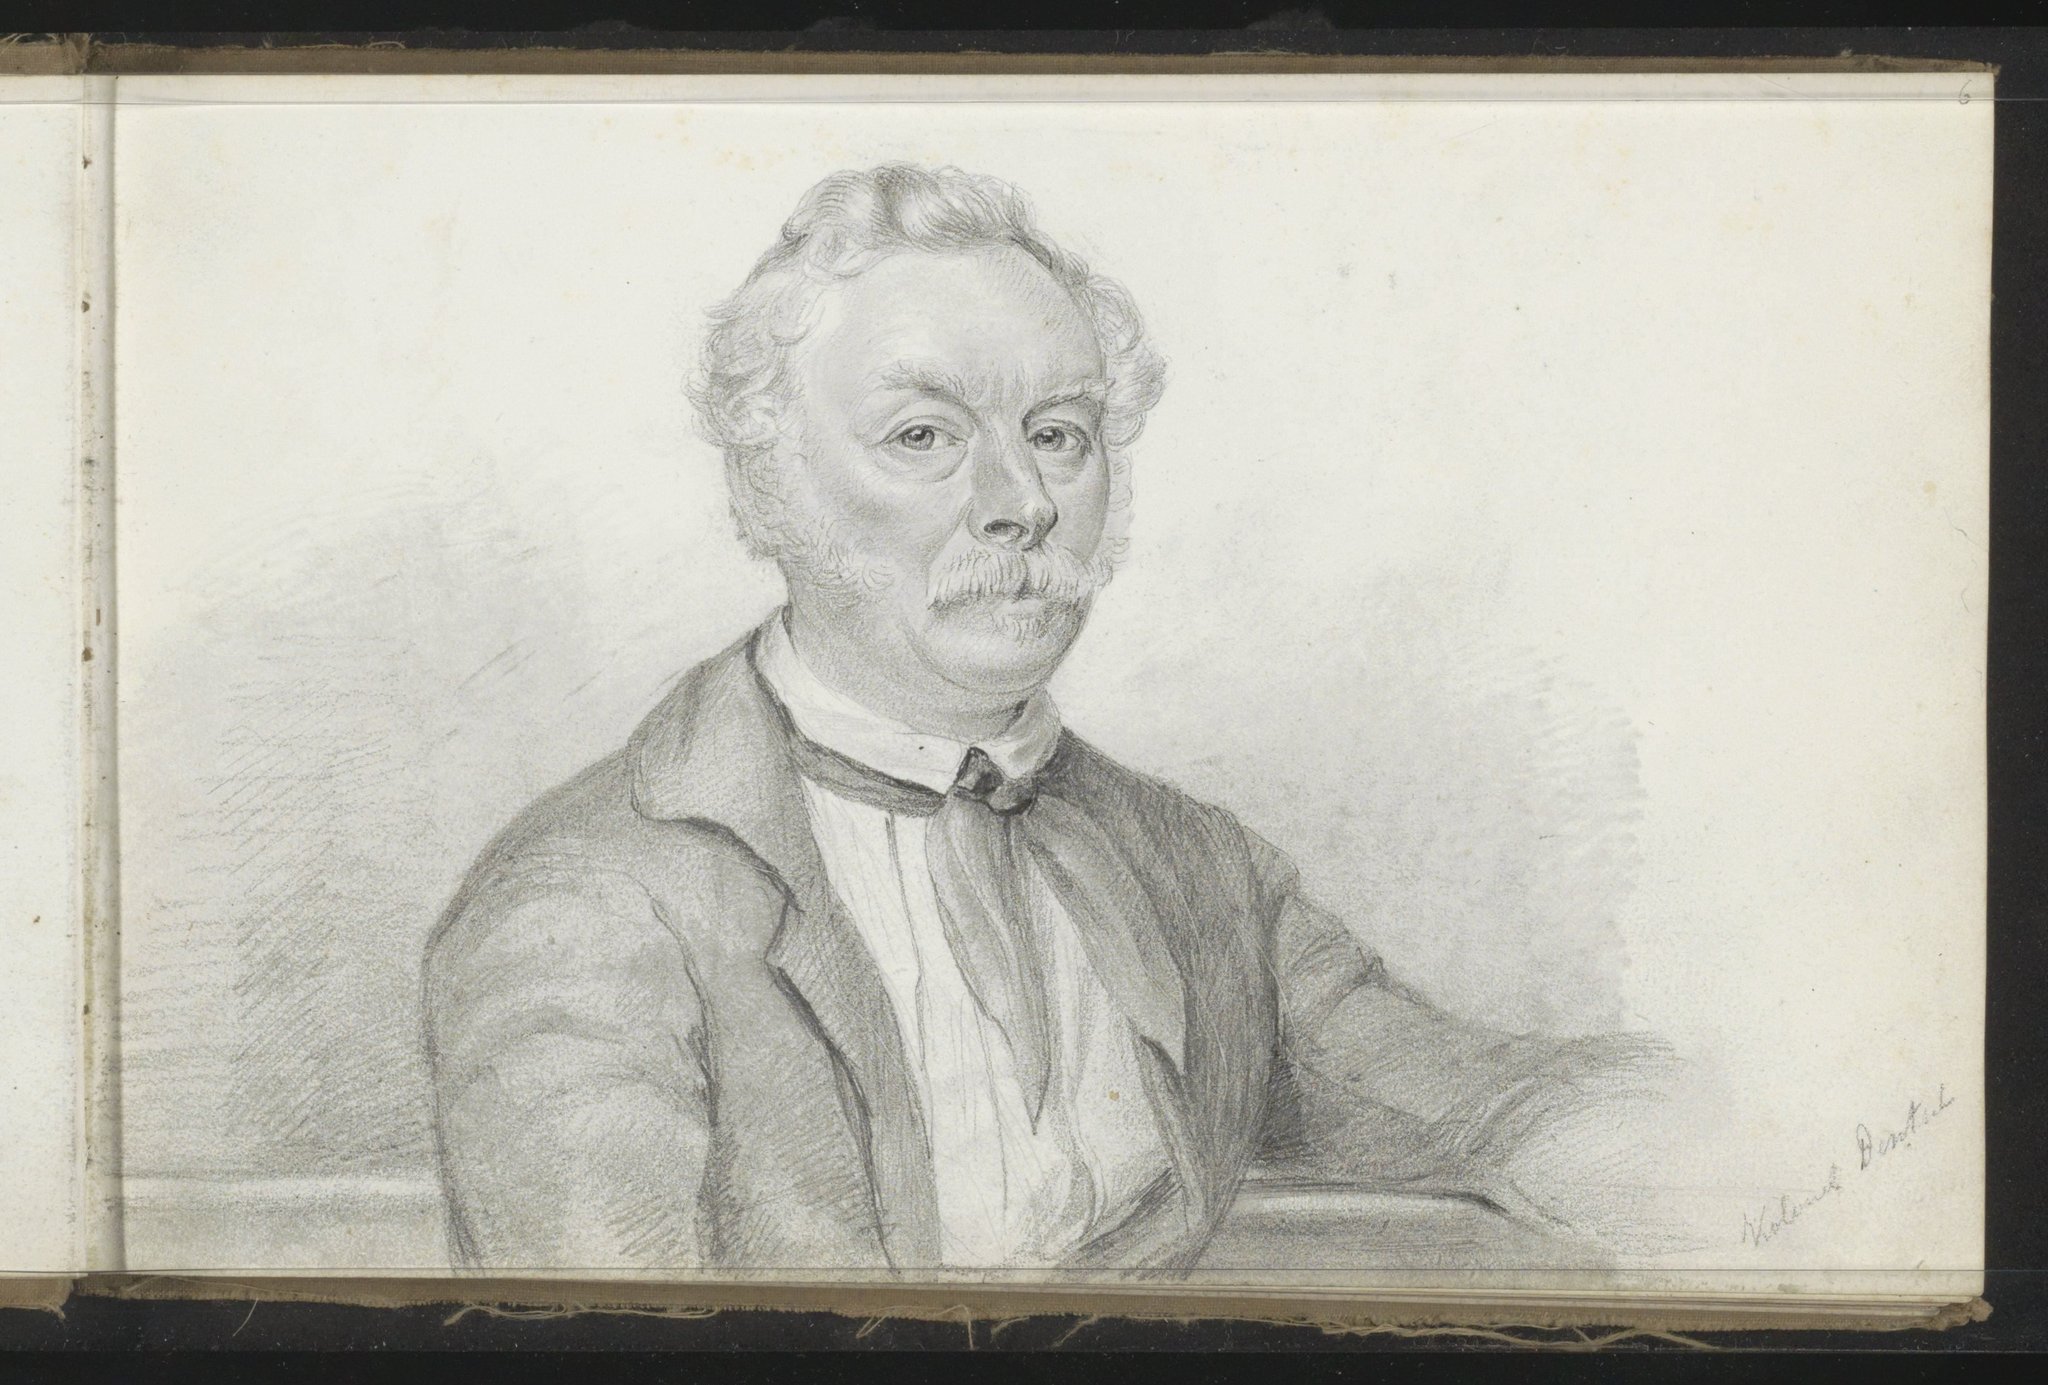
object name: sketchbook leaf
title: Portret van kolonel Dentsch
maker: christian heinrich gottlieb steuerwald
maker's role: draughtsman, print maker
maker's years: 1802-1874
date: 1848-1854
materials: paper, pencil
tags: historical persons (portraits and scenes from the life)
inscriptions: annotation: ‘Kolonel Dentsch’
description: Blad 6 recto uit een schetsboek met 58 bladen.